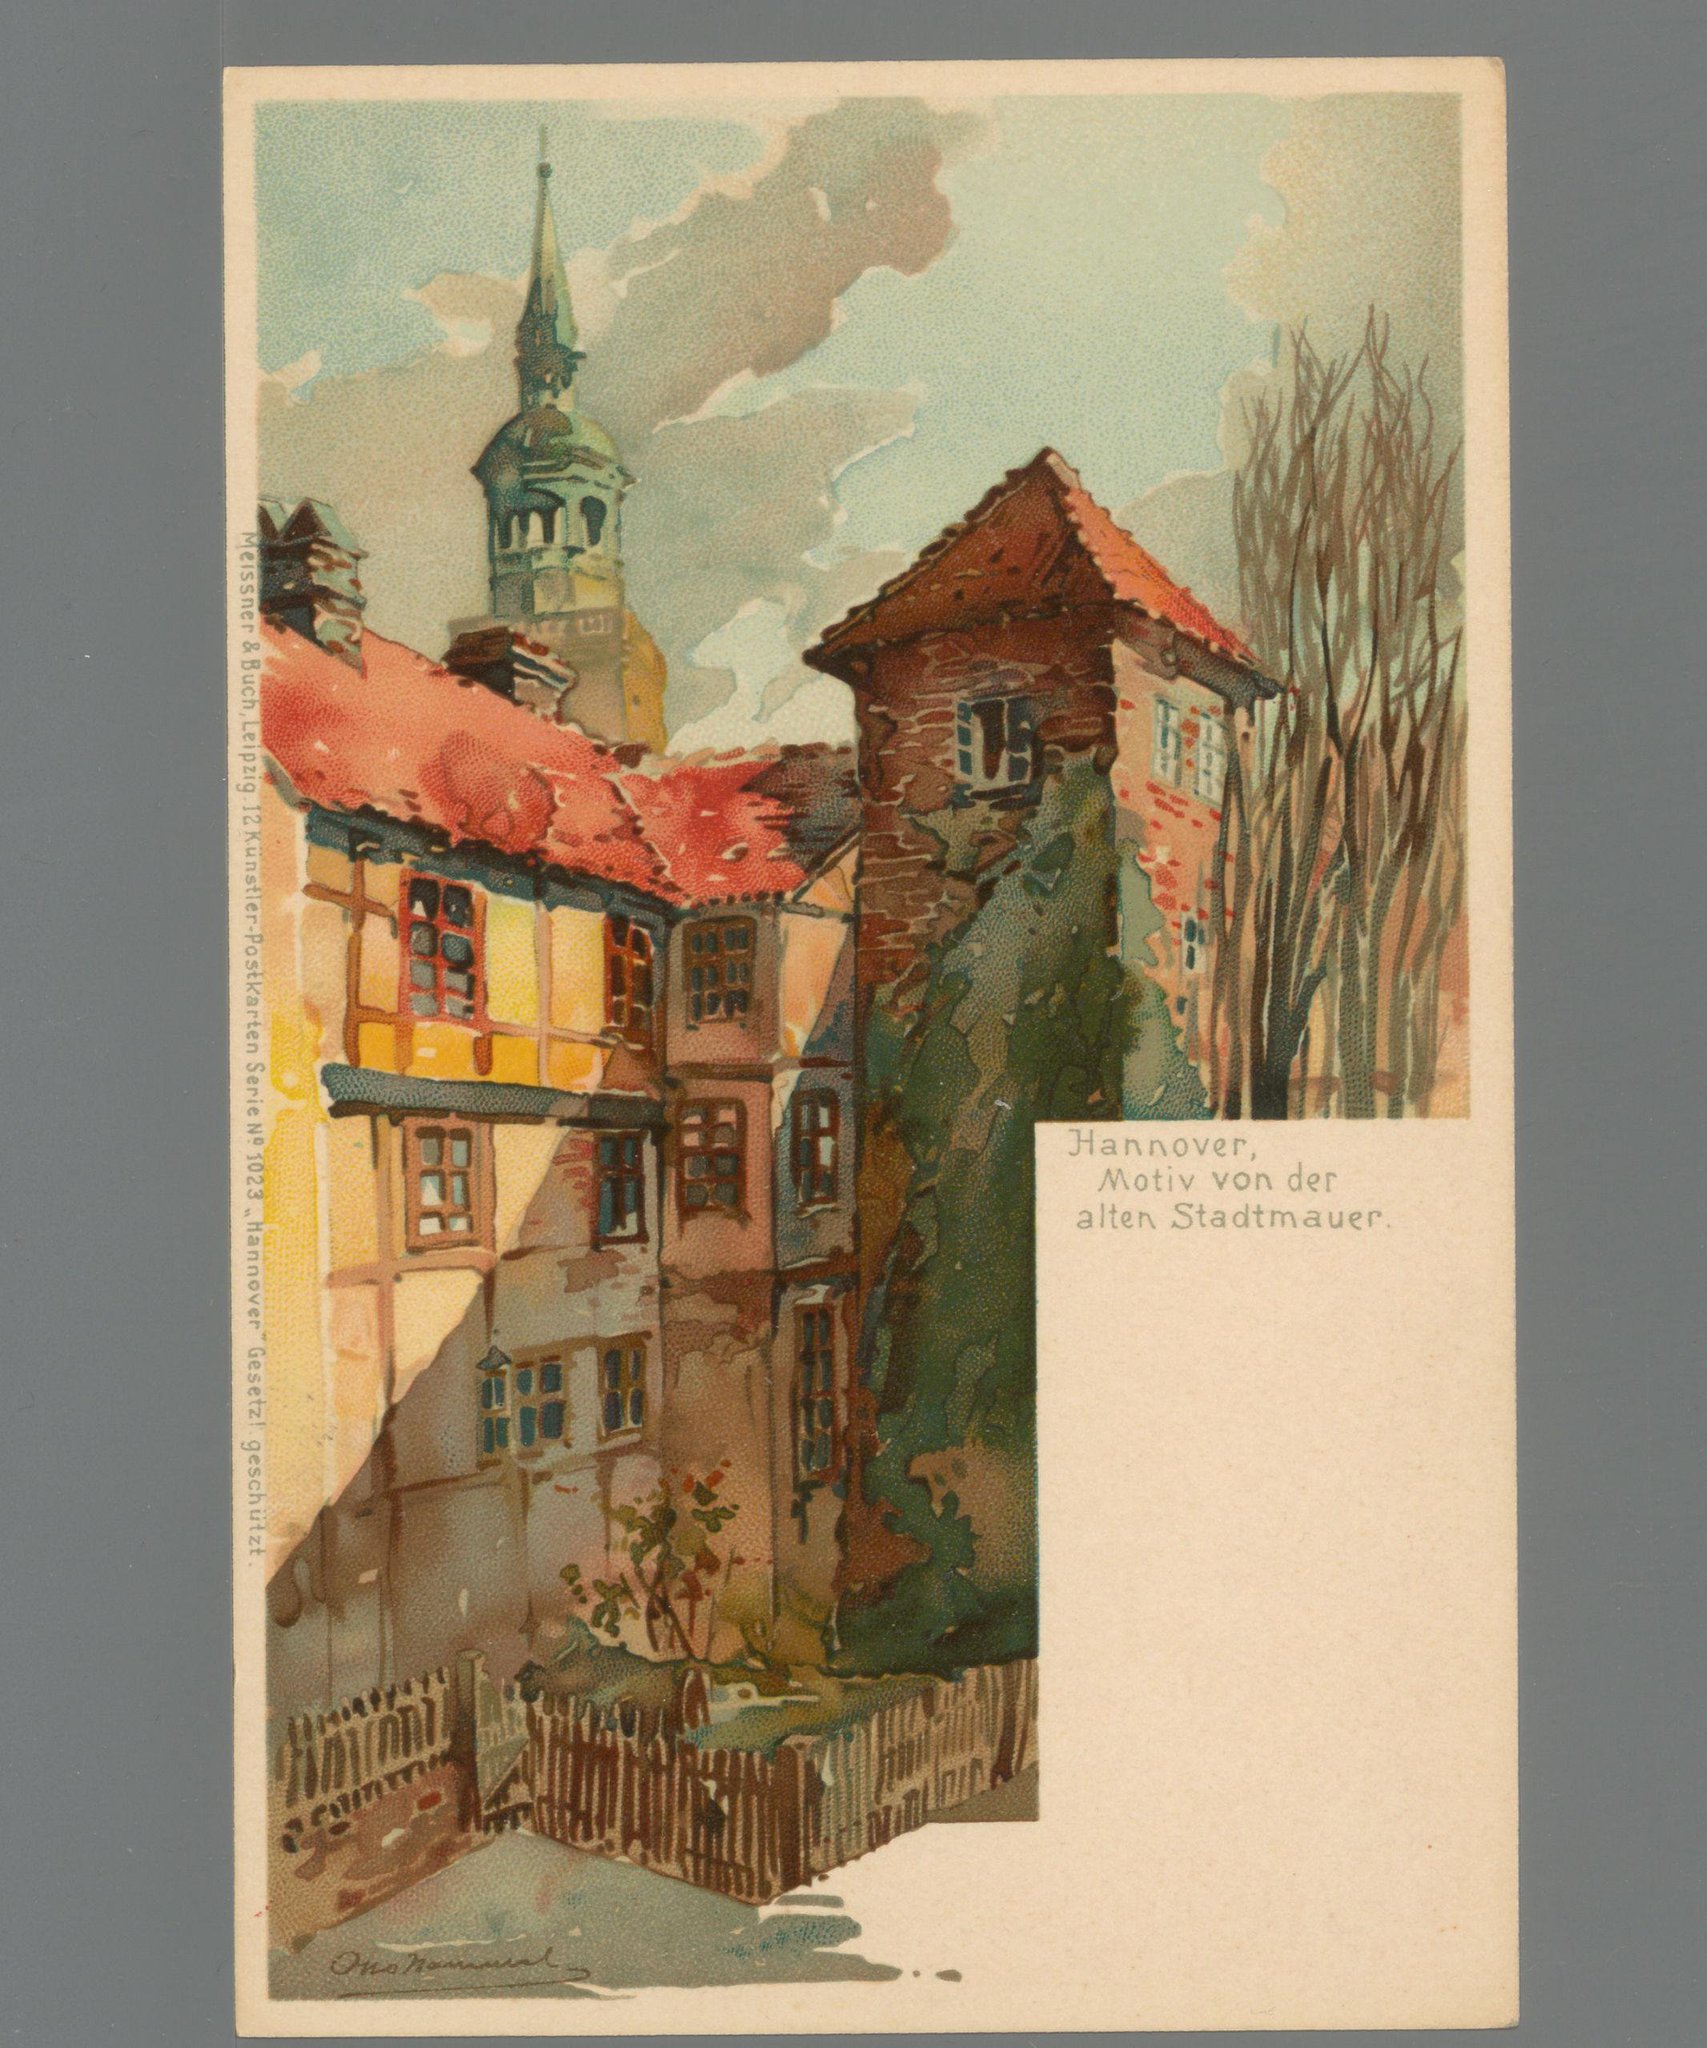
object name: print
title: Hannover, Motiv von der alten Stadtmauer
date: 1905-1930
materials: cardboard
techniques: lithograph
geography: leipzig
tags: towers ~ fortified city, city-walls